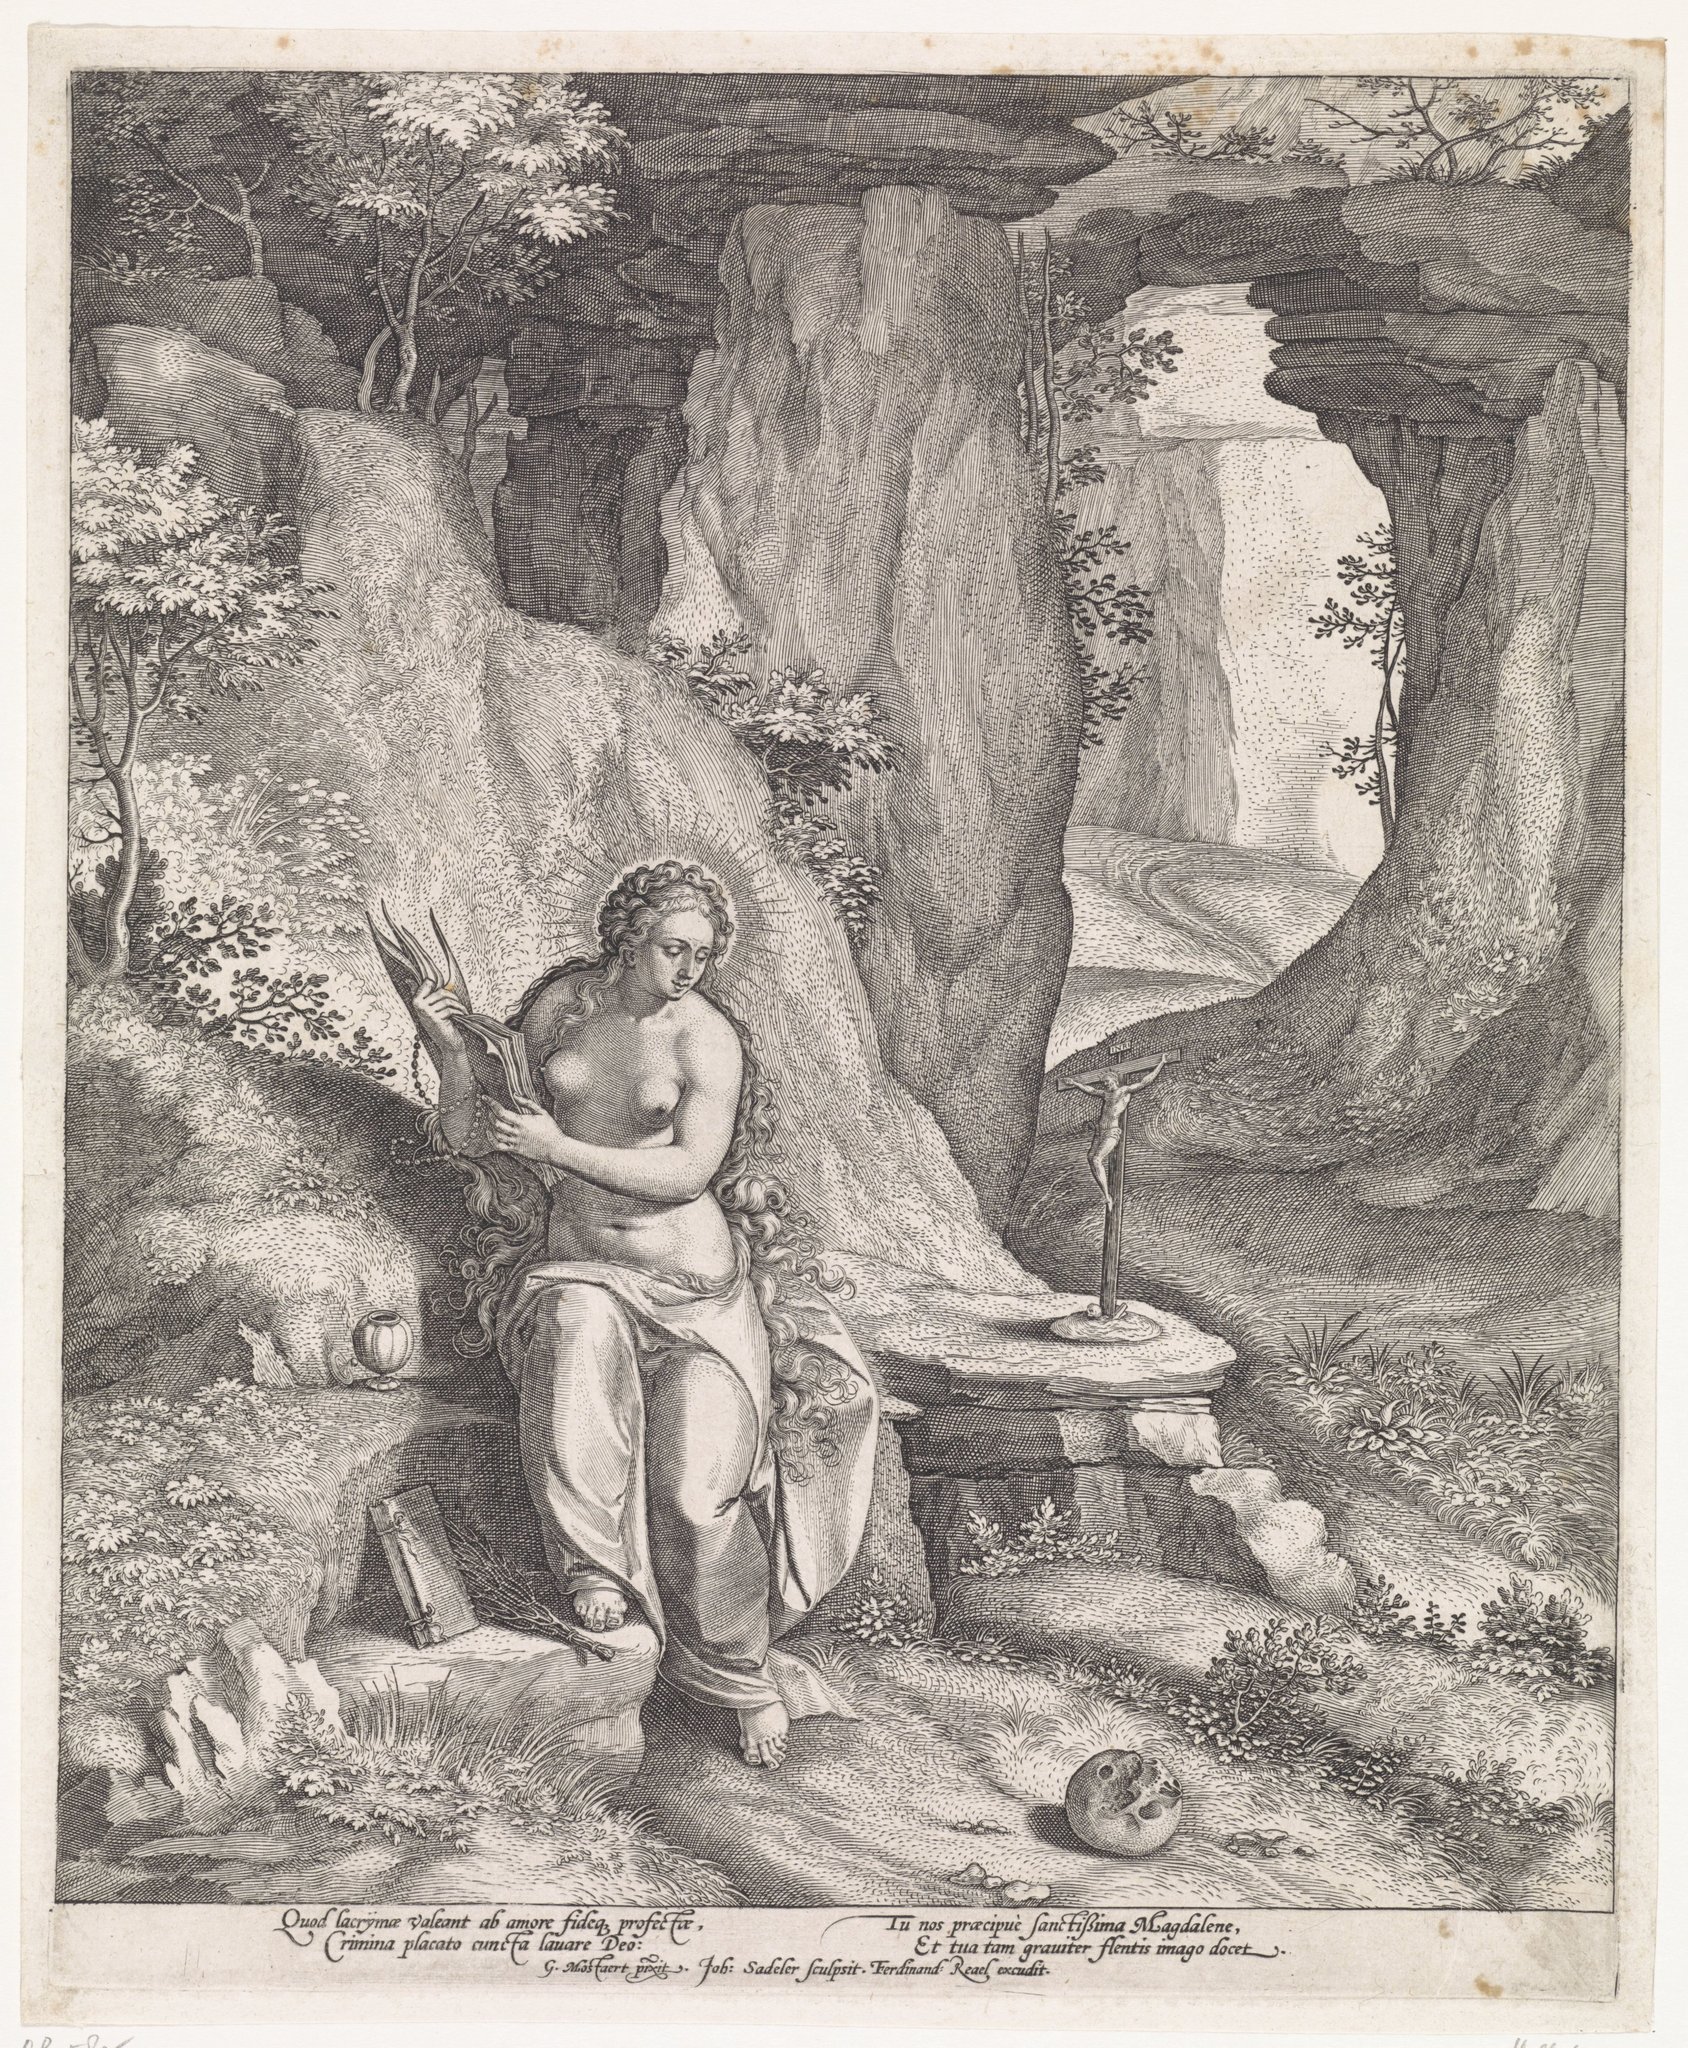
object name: print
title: Maria Magdalena in een grot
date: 1560-1600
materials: paper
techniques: engraving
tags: the penitent st. mary magdalene (often before a cave, possibly at la sainte-baume hill): her long hair covers her (naked) body, she reads, meditates or raises her tear-filled eyes towards heaven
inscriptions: collector's mark: Lugt 240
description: De boetvaardige Maria Magdalena als kluizenares in een grot. Ze leest de bijbel. Rondom haar een crucifix, een roede en een zalfpot. De prent heeft een Latijns onderschrift met uitleg.